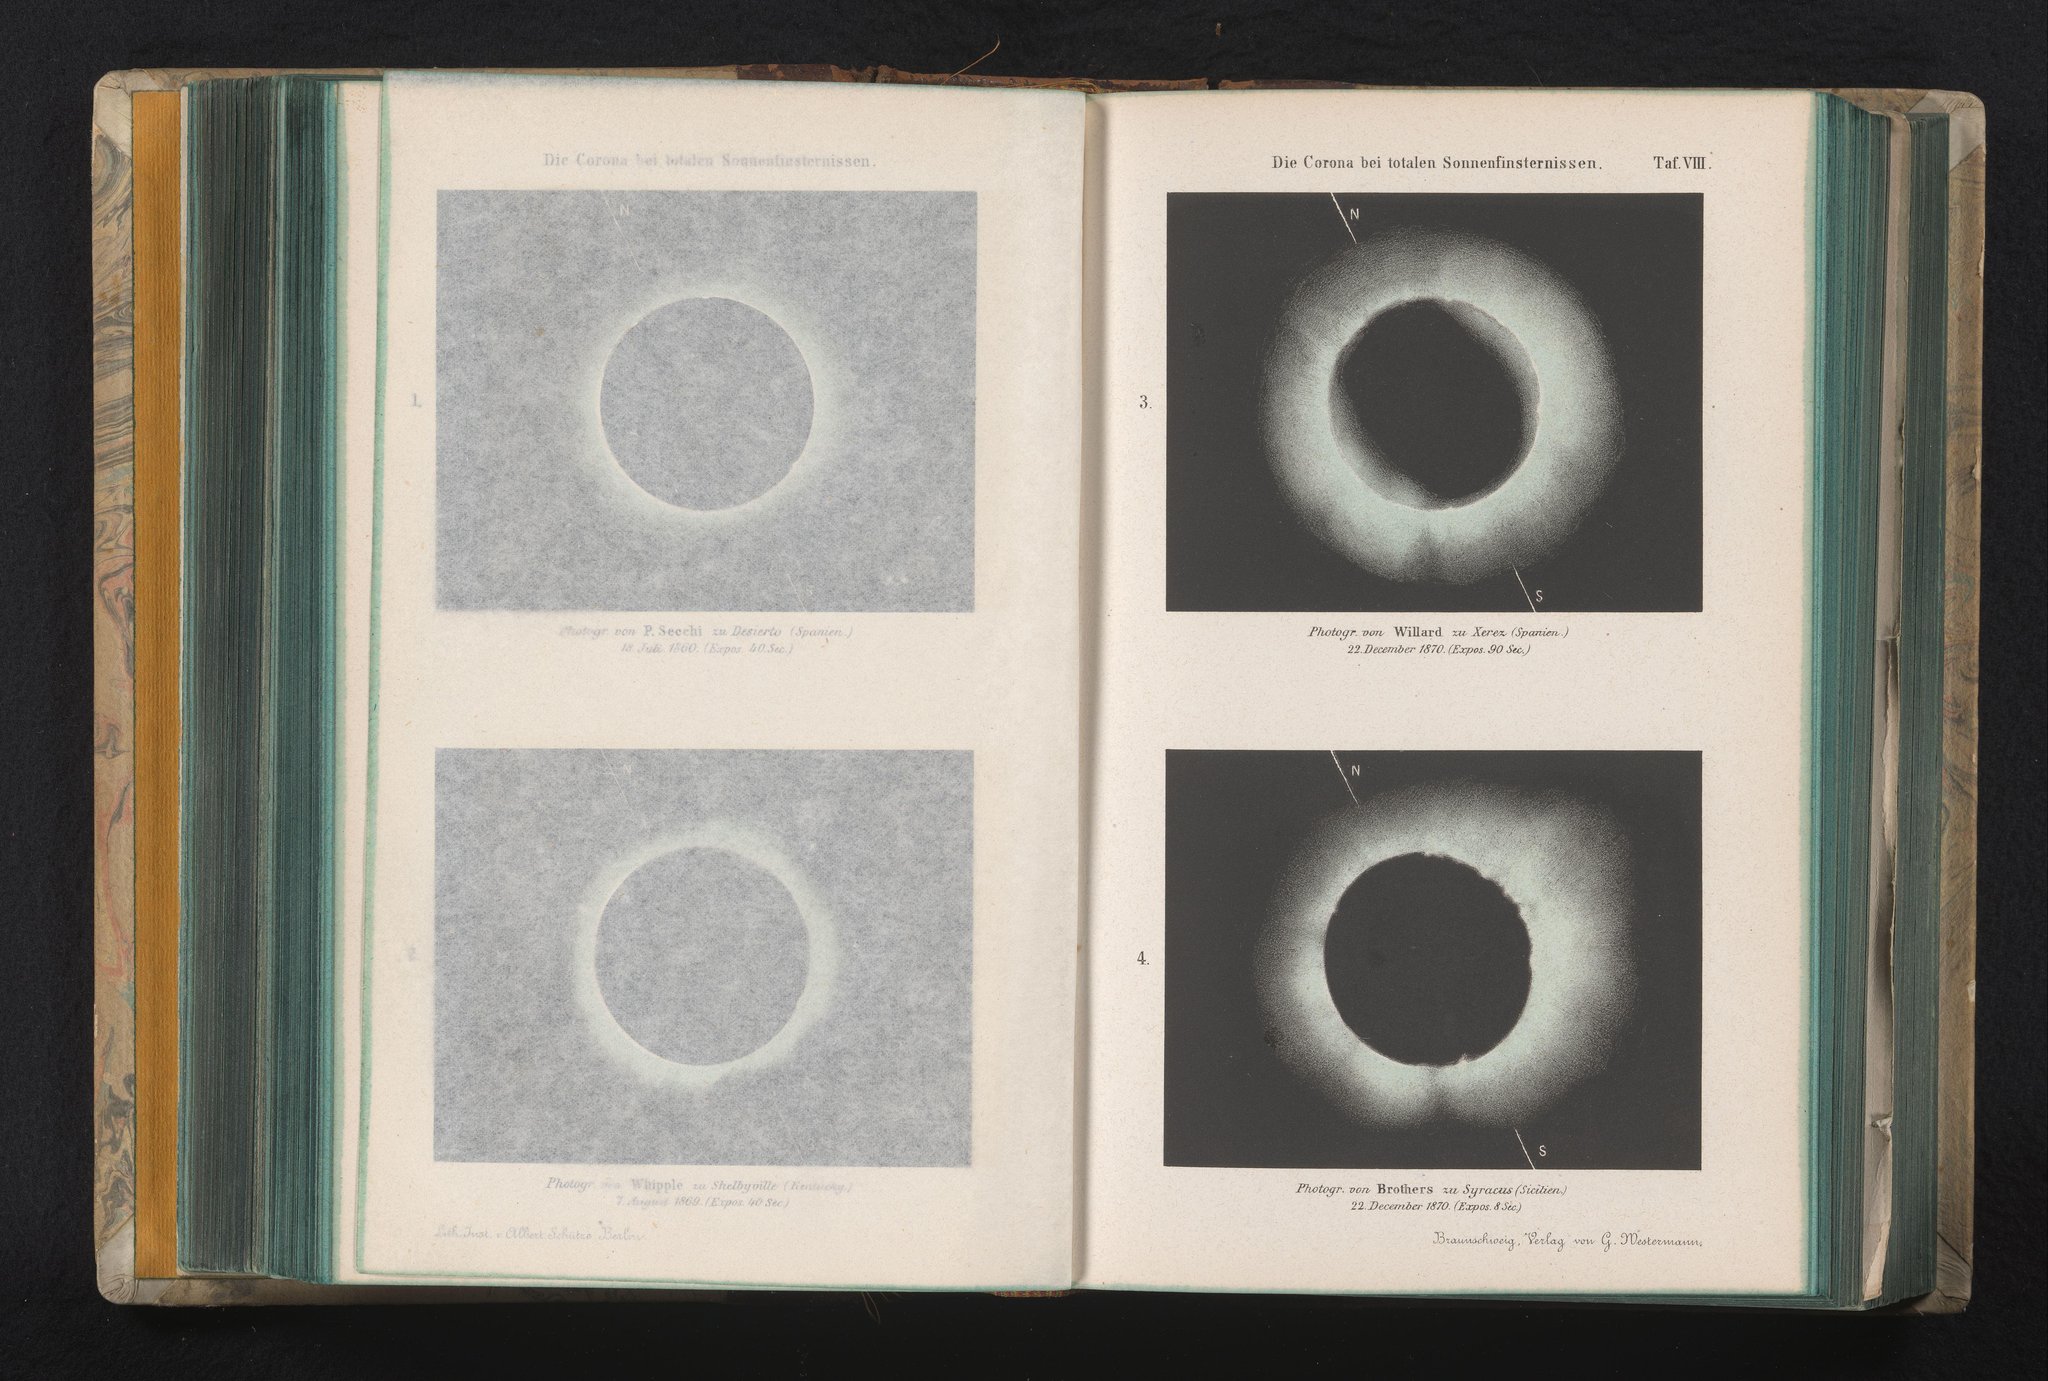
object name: print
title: Die Corona bei totalen Sonnenfinsternissen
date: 1870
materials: paper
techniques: lithograph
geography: braunschweig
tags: total solar eclipse with corona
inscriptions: number: ‘4.’, inscription: ‘Photogr. von Brothers zu Syracuse (Sicilien.)/ 22. December 1870. (Expos. 8 Sec.)’, inscription: ‘Taf. VIII.’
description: Prent op derde ongenummerde pagina na pagina 320.